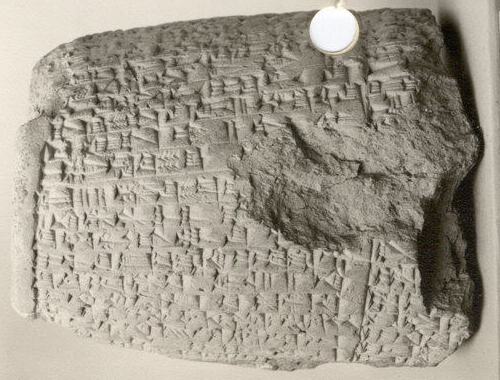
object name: cuneiform cylinder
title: Cuneiform cylinder: inscription of Nabonidus describing work on Ebabbar, the temple of the sun-god Shamash, at Sippar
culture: babylonian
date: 555-539 BCE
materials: clay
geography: mesopotamia